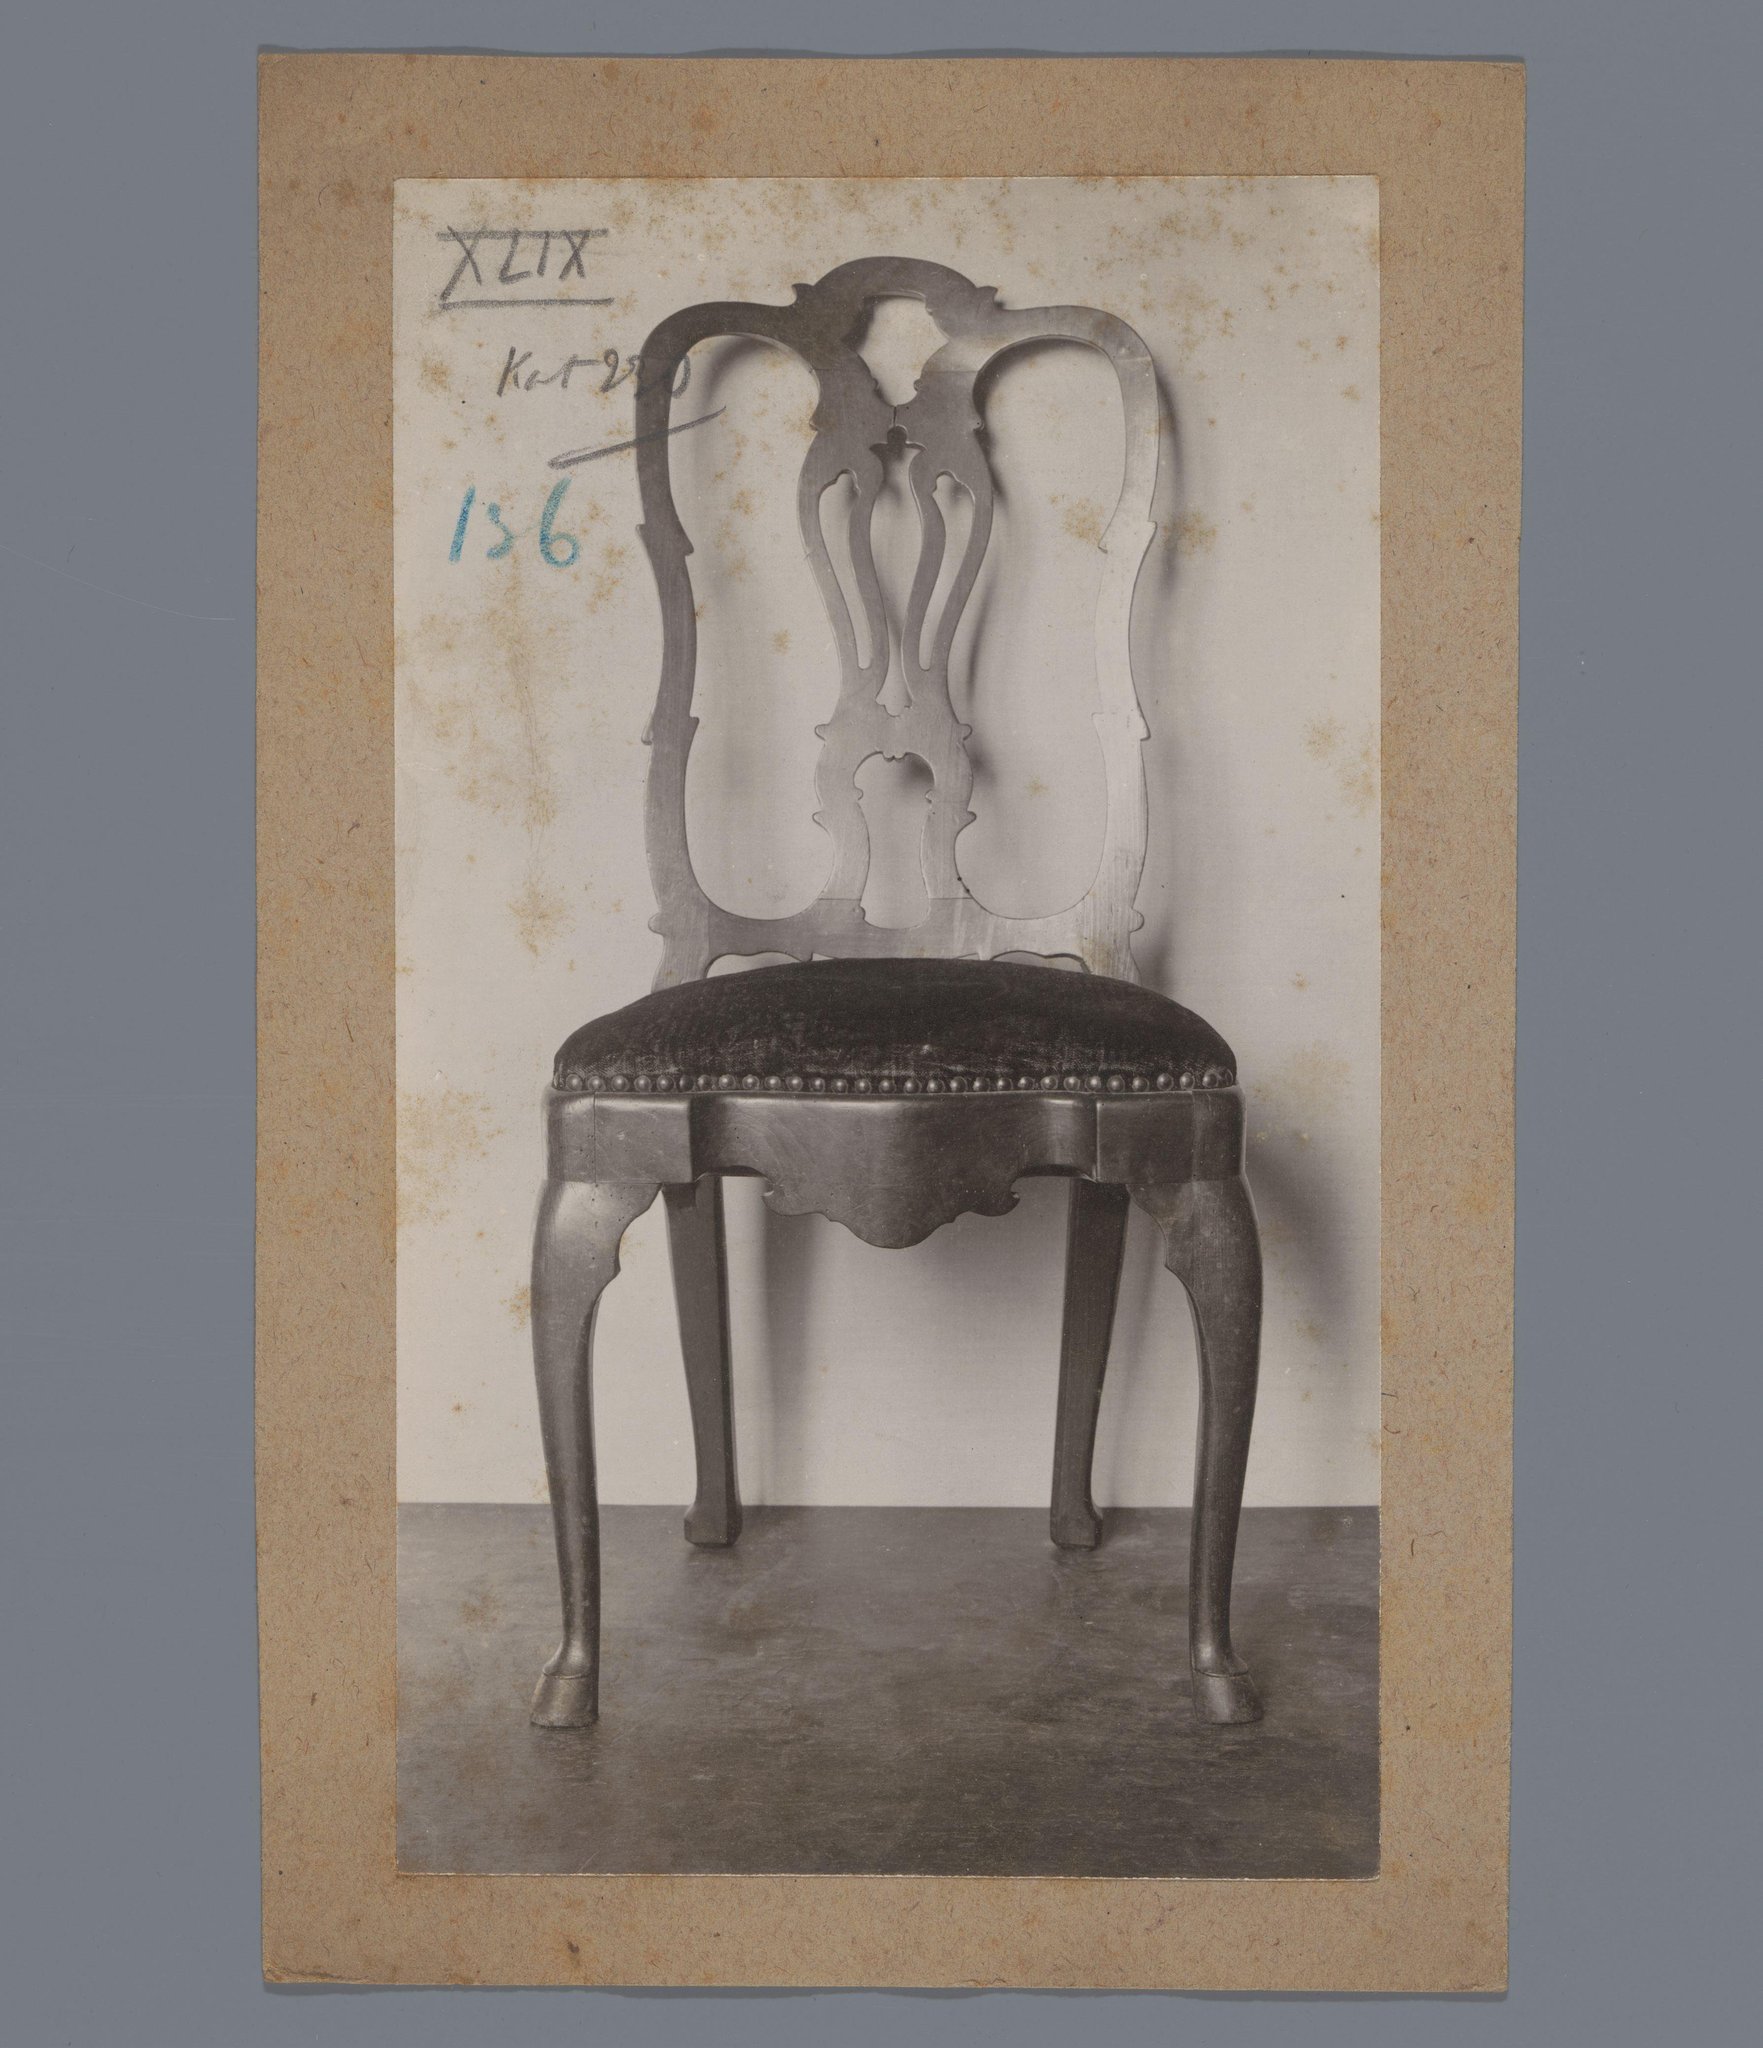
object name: photograph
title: Stoel met een opengewerkte rug (vermoedelijk) in het Rijksmuseum te Amsterdam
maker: Anonymous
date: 1875-1900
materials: photographic support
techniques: matte daylight collodion silver print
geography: amsterdam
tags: chair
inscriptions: number: ‘XLIX kat 230 136’, collector's mark: ‘Instituut voor kunst-nijverheidsonderwijs Gabriël Metsustraat No. 16, Amsterdam’, collector's mark: ‘Kunstnijverheidschool Quellinus Amsterdam Frans Halsstraat 14.’